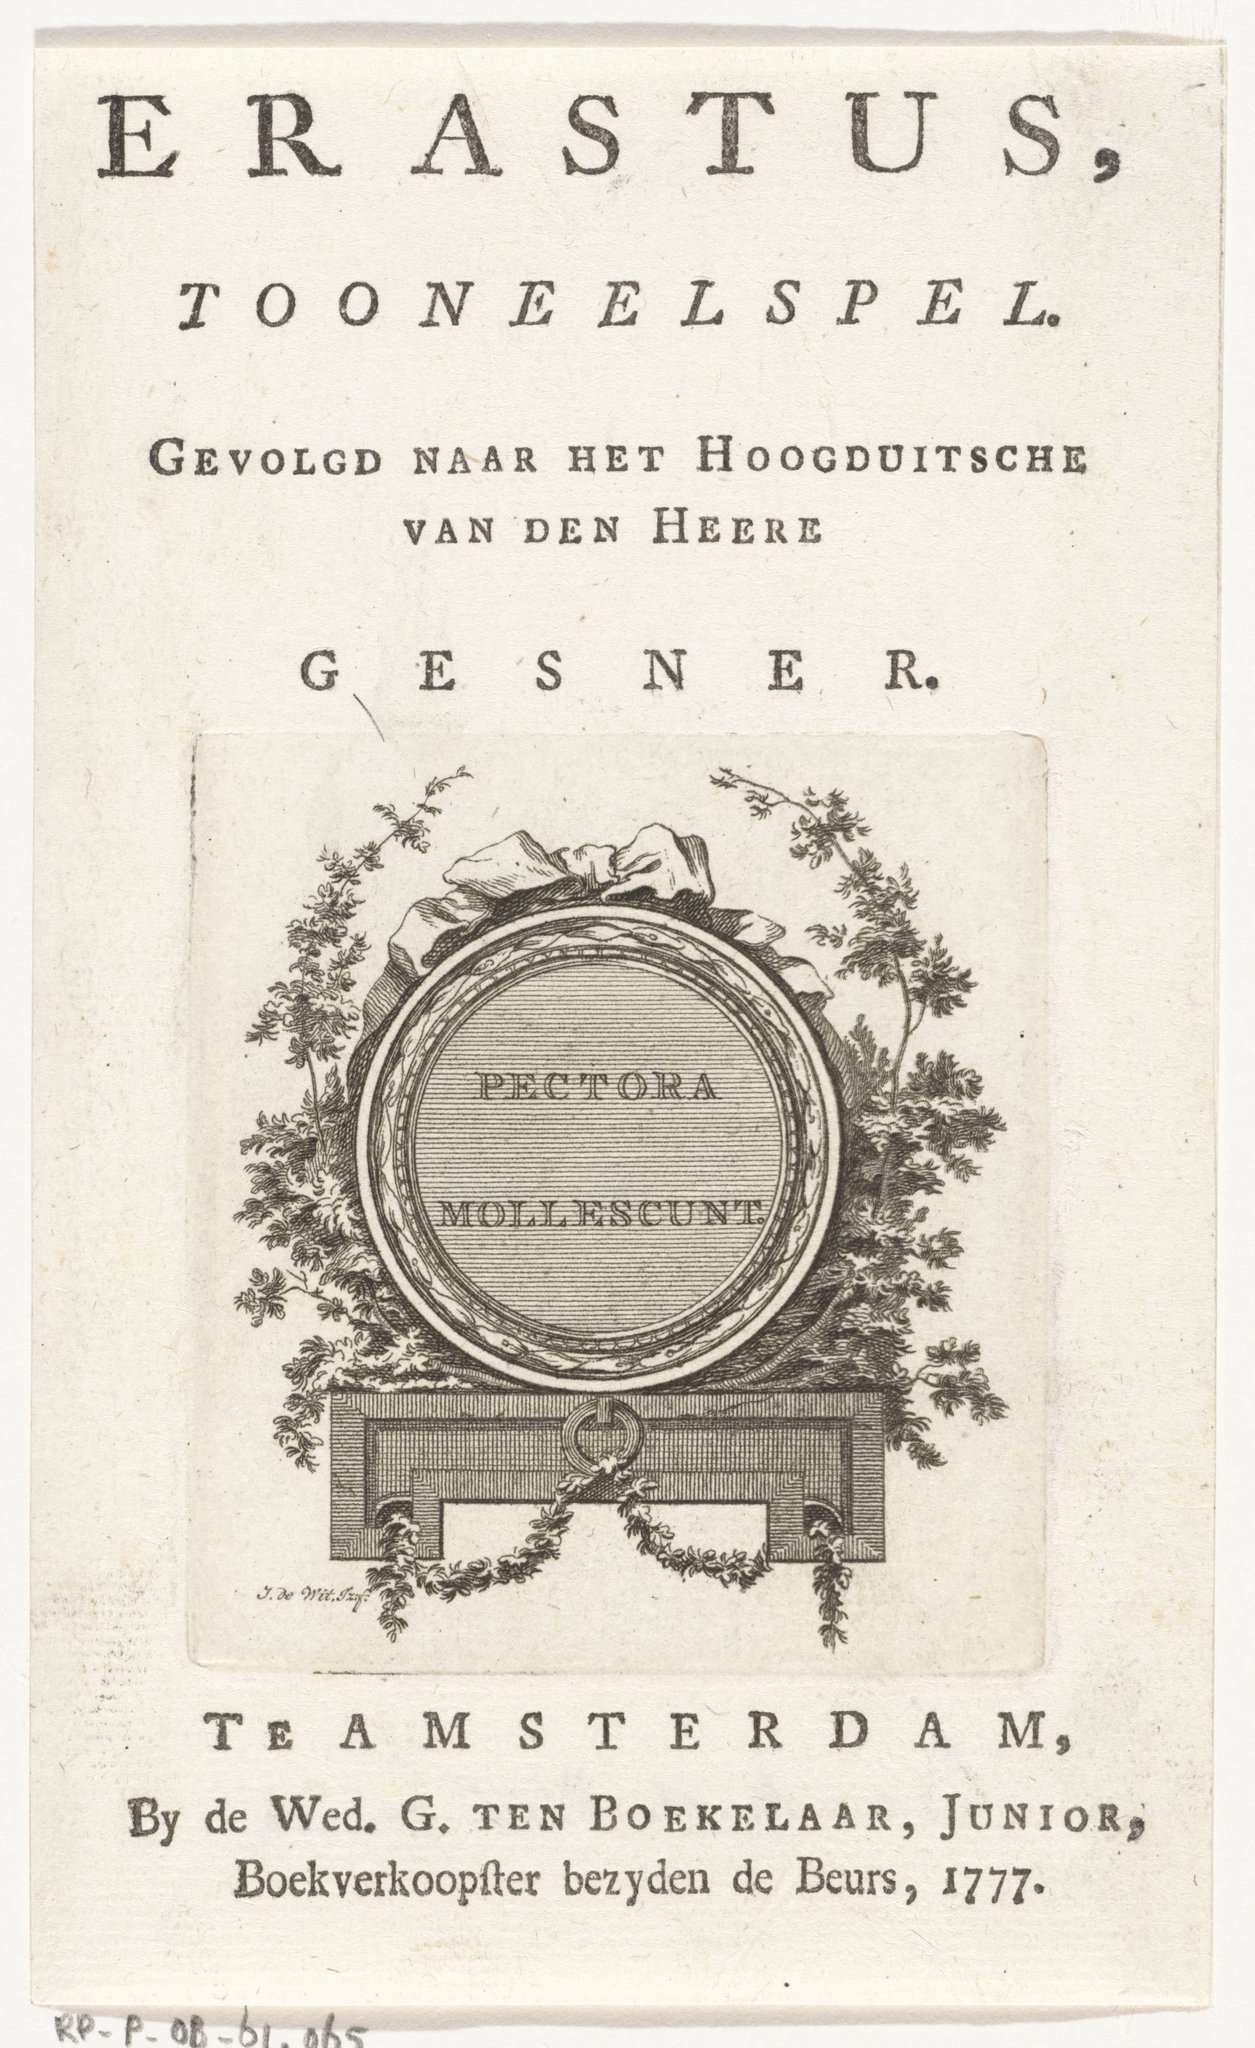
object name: titelblad, titelpagina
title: Medaillon met takken omgeven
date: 1777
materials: paper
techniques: etching, letterpress printing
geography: amsterdam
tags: ornament ~ medallion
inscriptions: collector's mark: Lugt 2228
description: Titelpagina voor: Gesner, Salomon. Erastus: tooneelspel. Amterdam: Weduwe G. ten Boekelaar Junior, 1777.